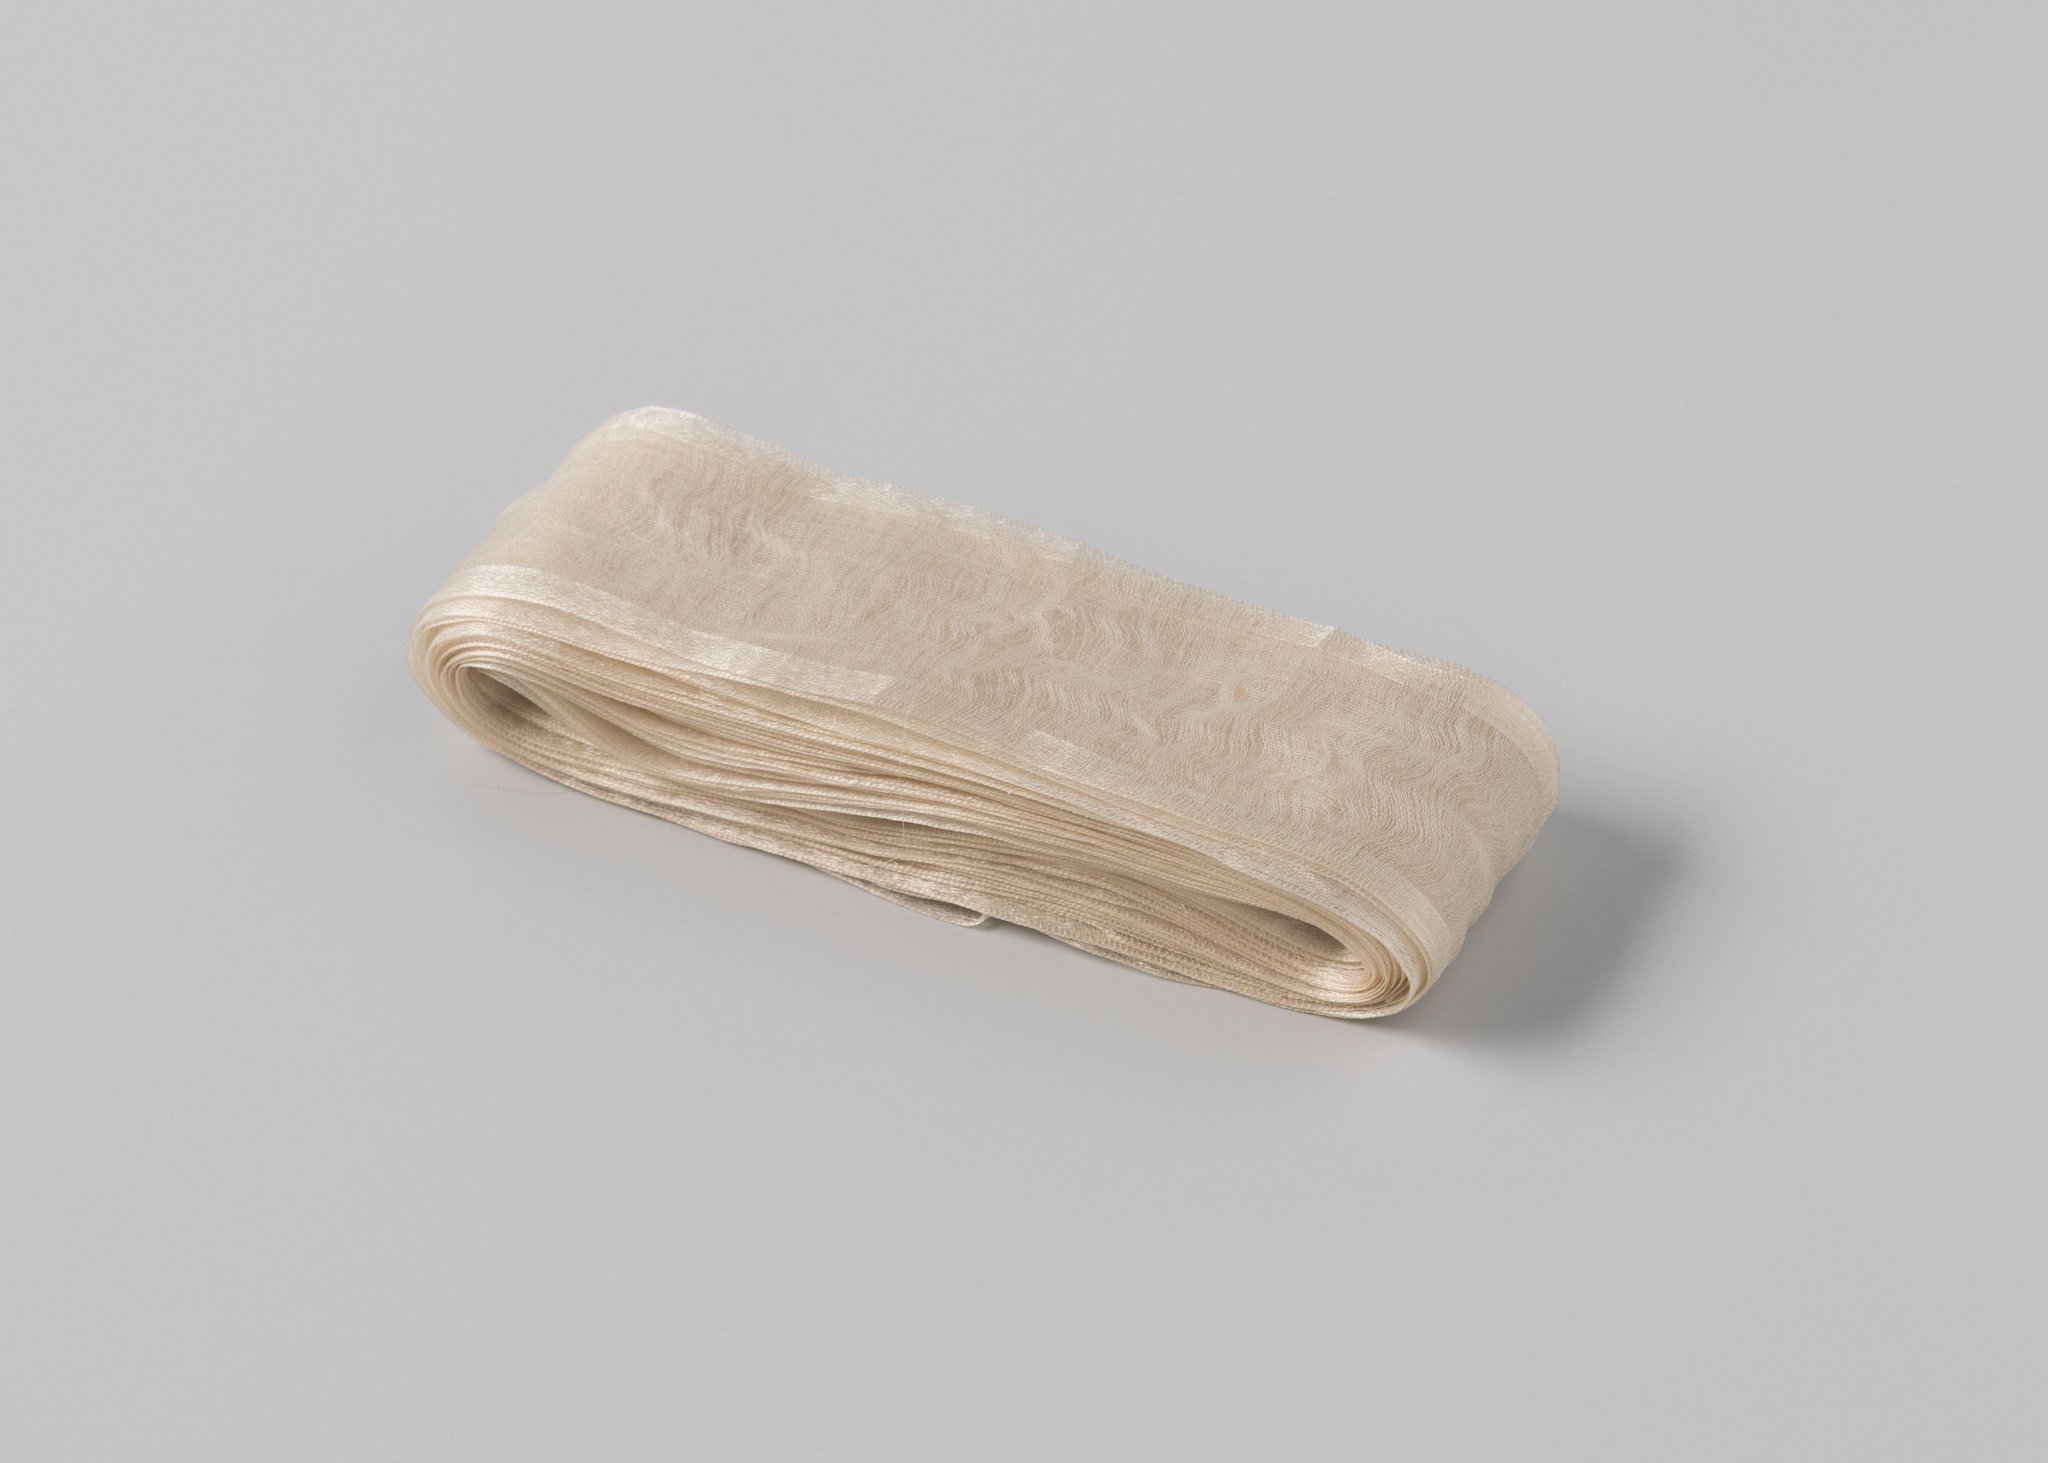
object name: ribbon material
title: Lint van crèmekleurig gaas van 15 meter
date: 1900-1915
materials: textile, silk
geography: nijmegen